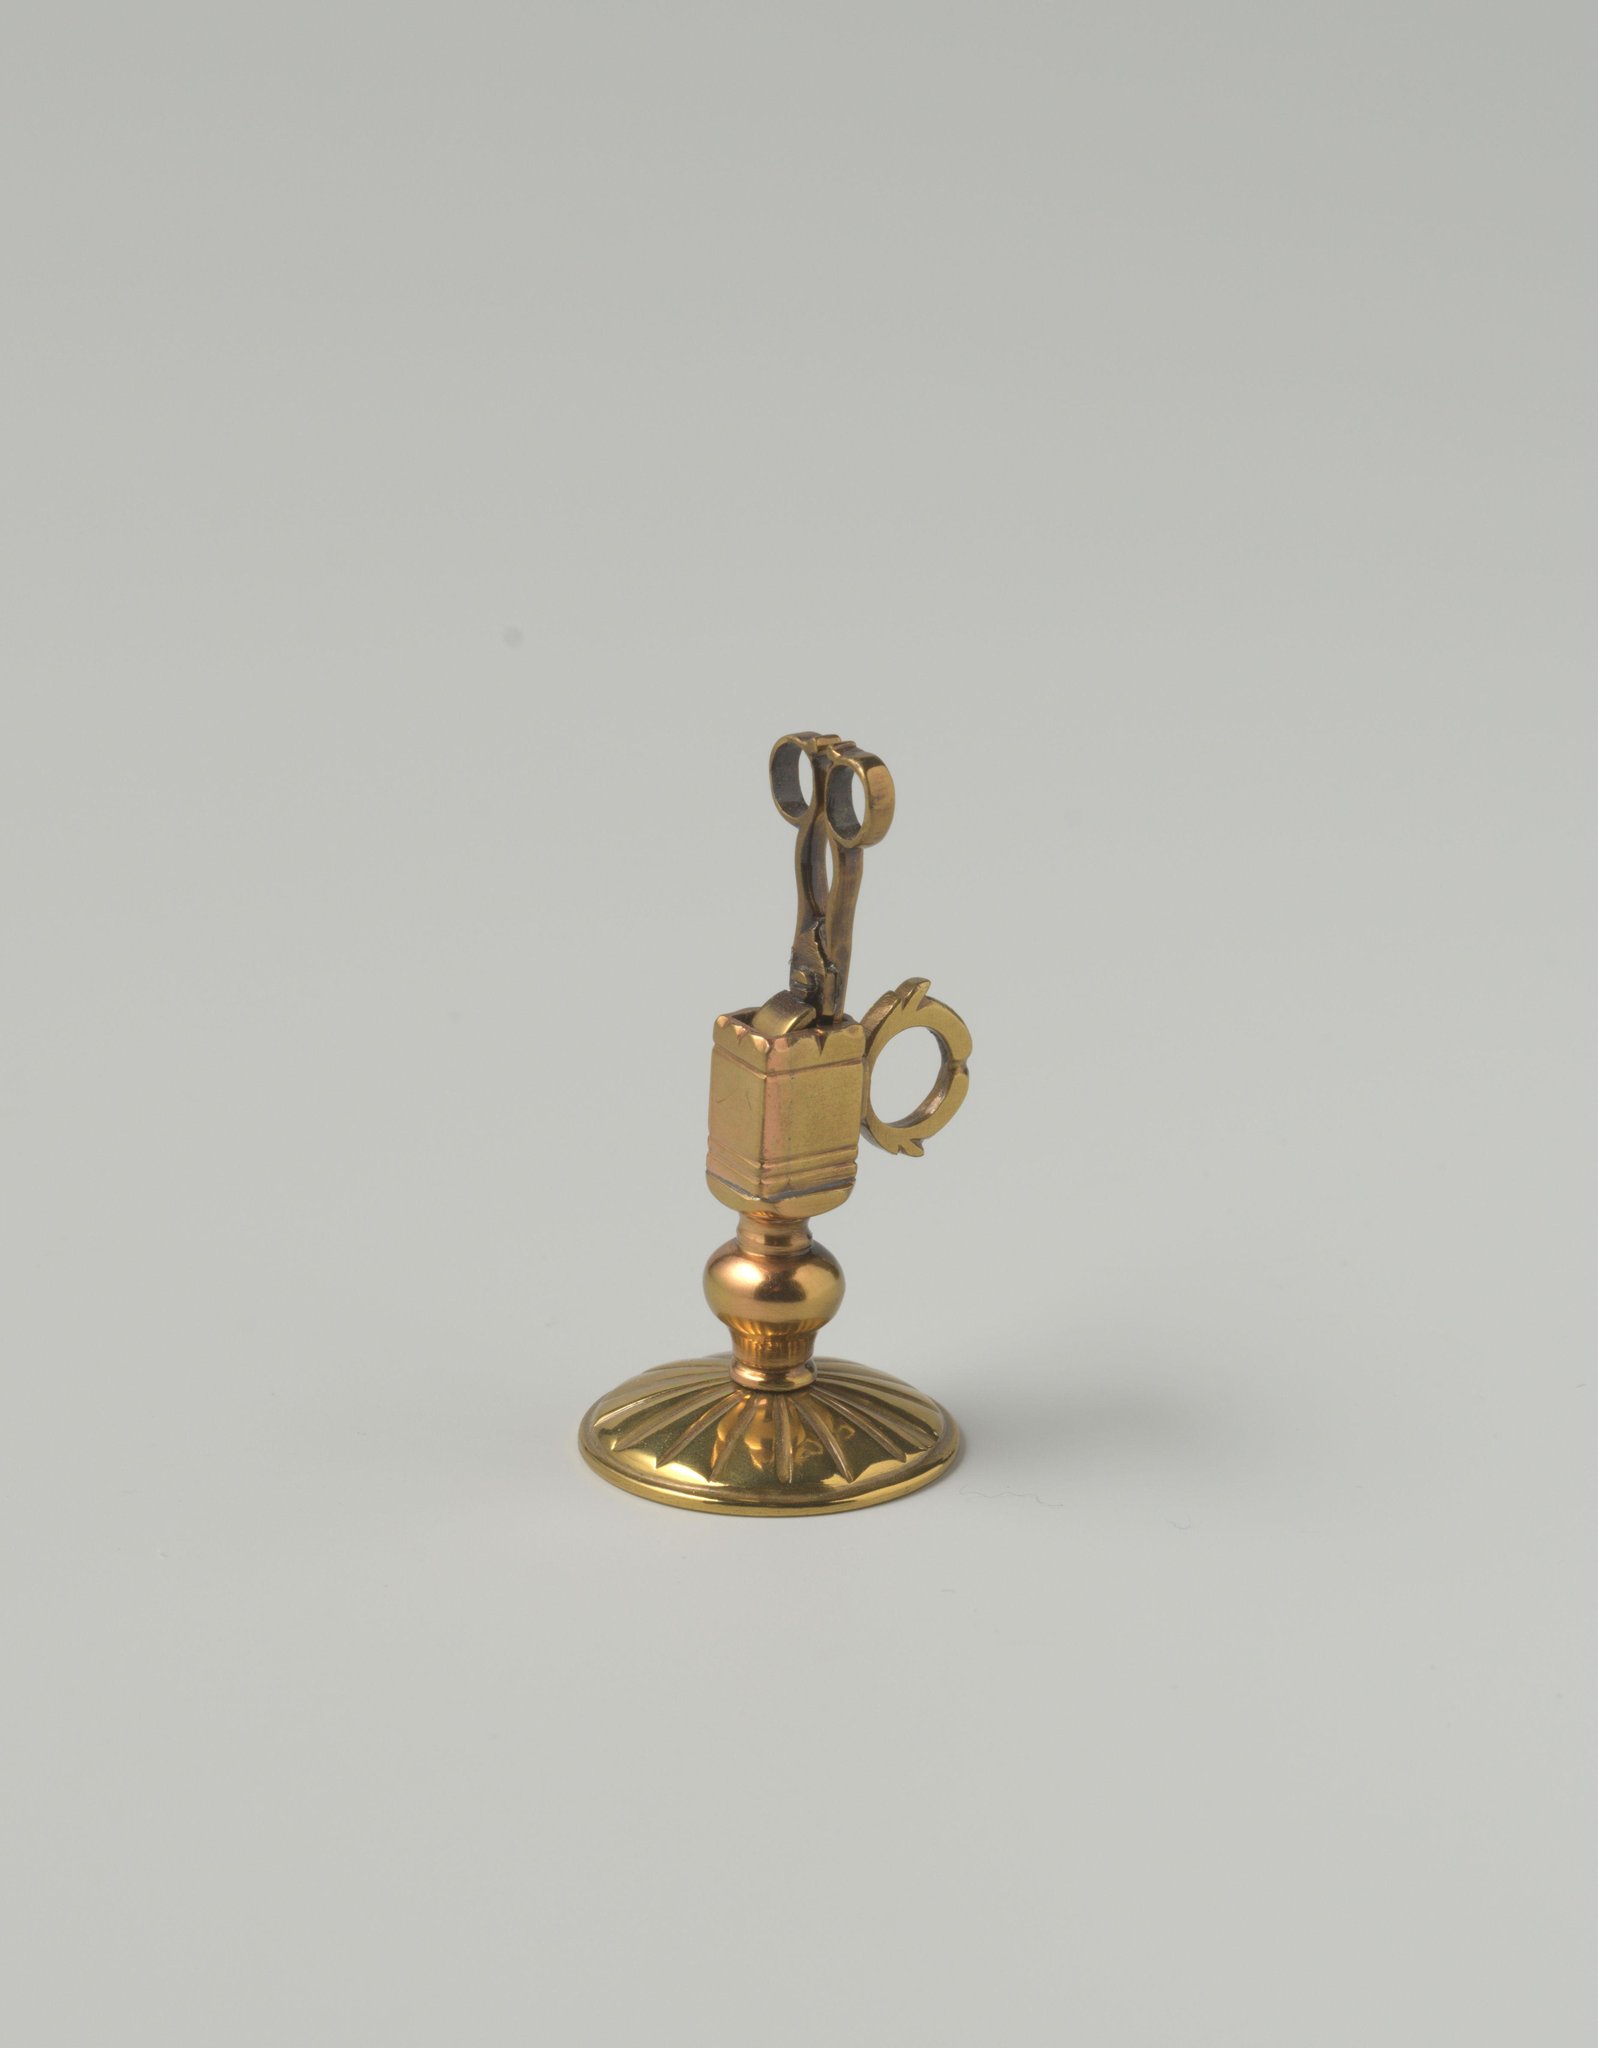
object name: miniature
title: Koperen kaarsensnuiter, openscharende snuiter met pit bakje en scherpe punt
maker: Anonymous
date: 1690-1710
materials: copper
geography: amsterdam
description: Koperen kaarsensnuiter in standaard; openscharende snuiter met pitbakje en scherpe punt.